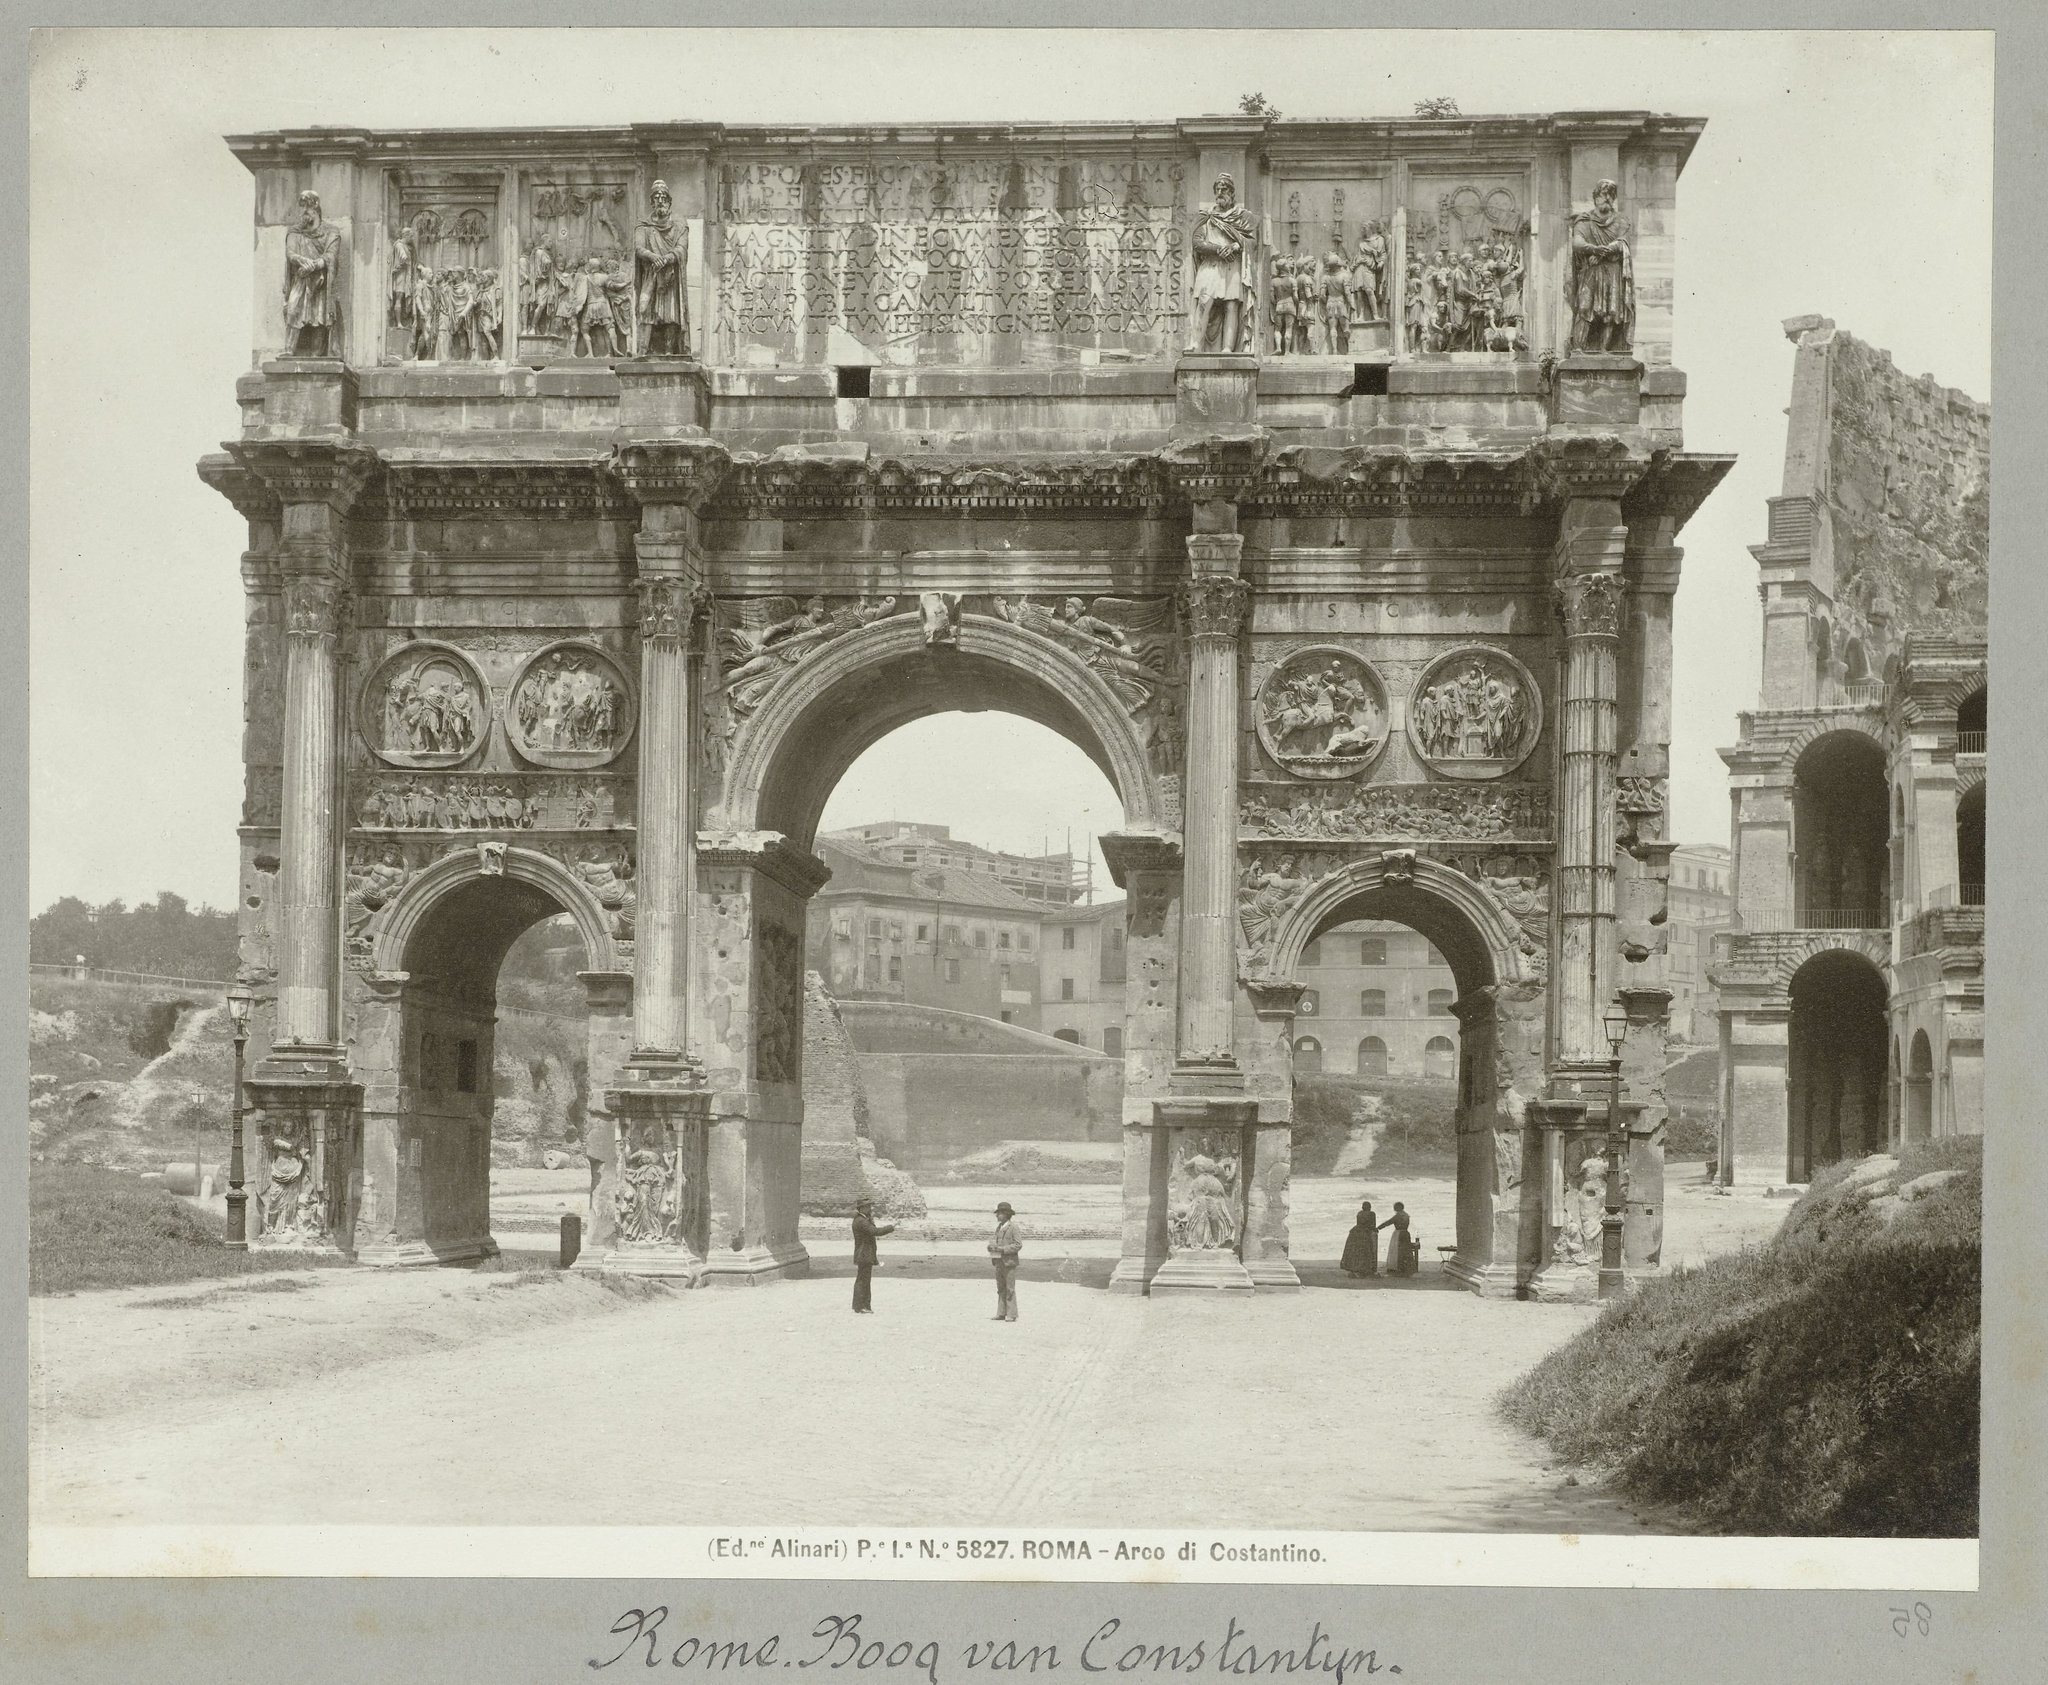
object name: photograph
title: P.I.N.5827 Roma - Arco di Constantino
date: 1893-1903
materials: cardboard, photographic support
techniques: albumen print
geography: rome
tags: arch of constantine